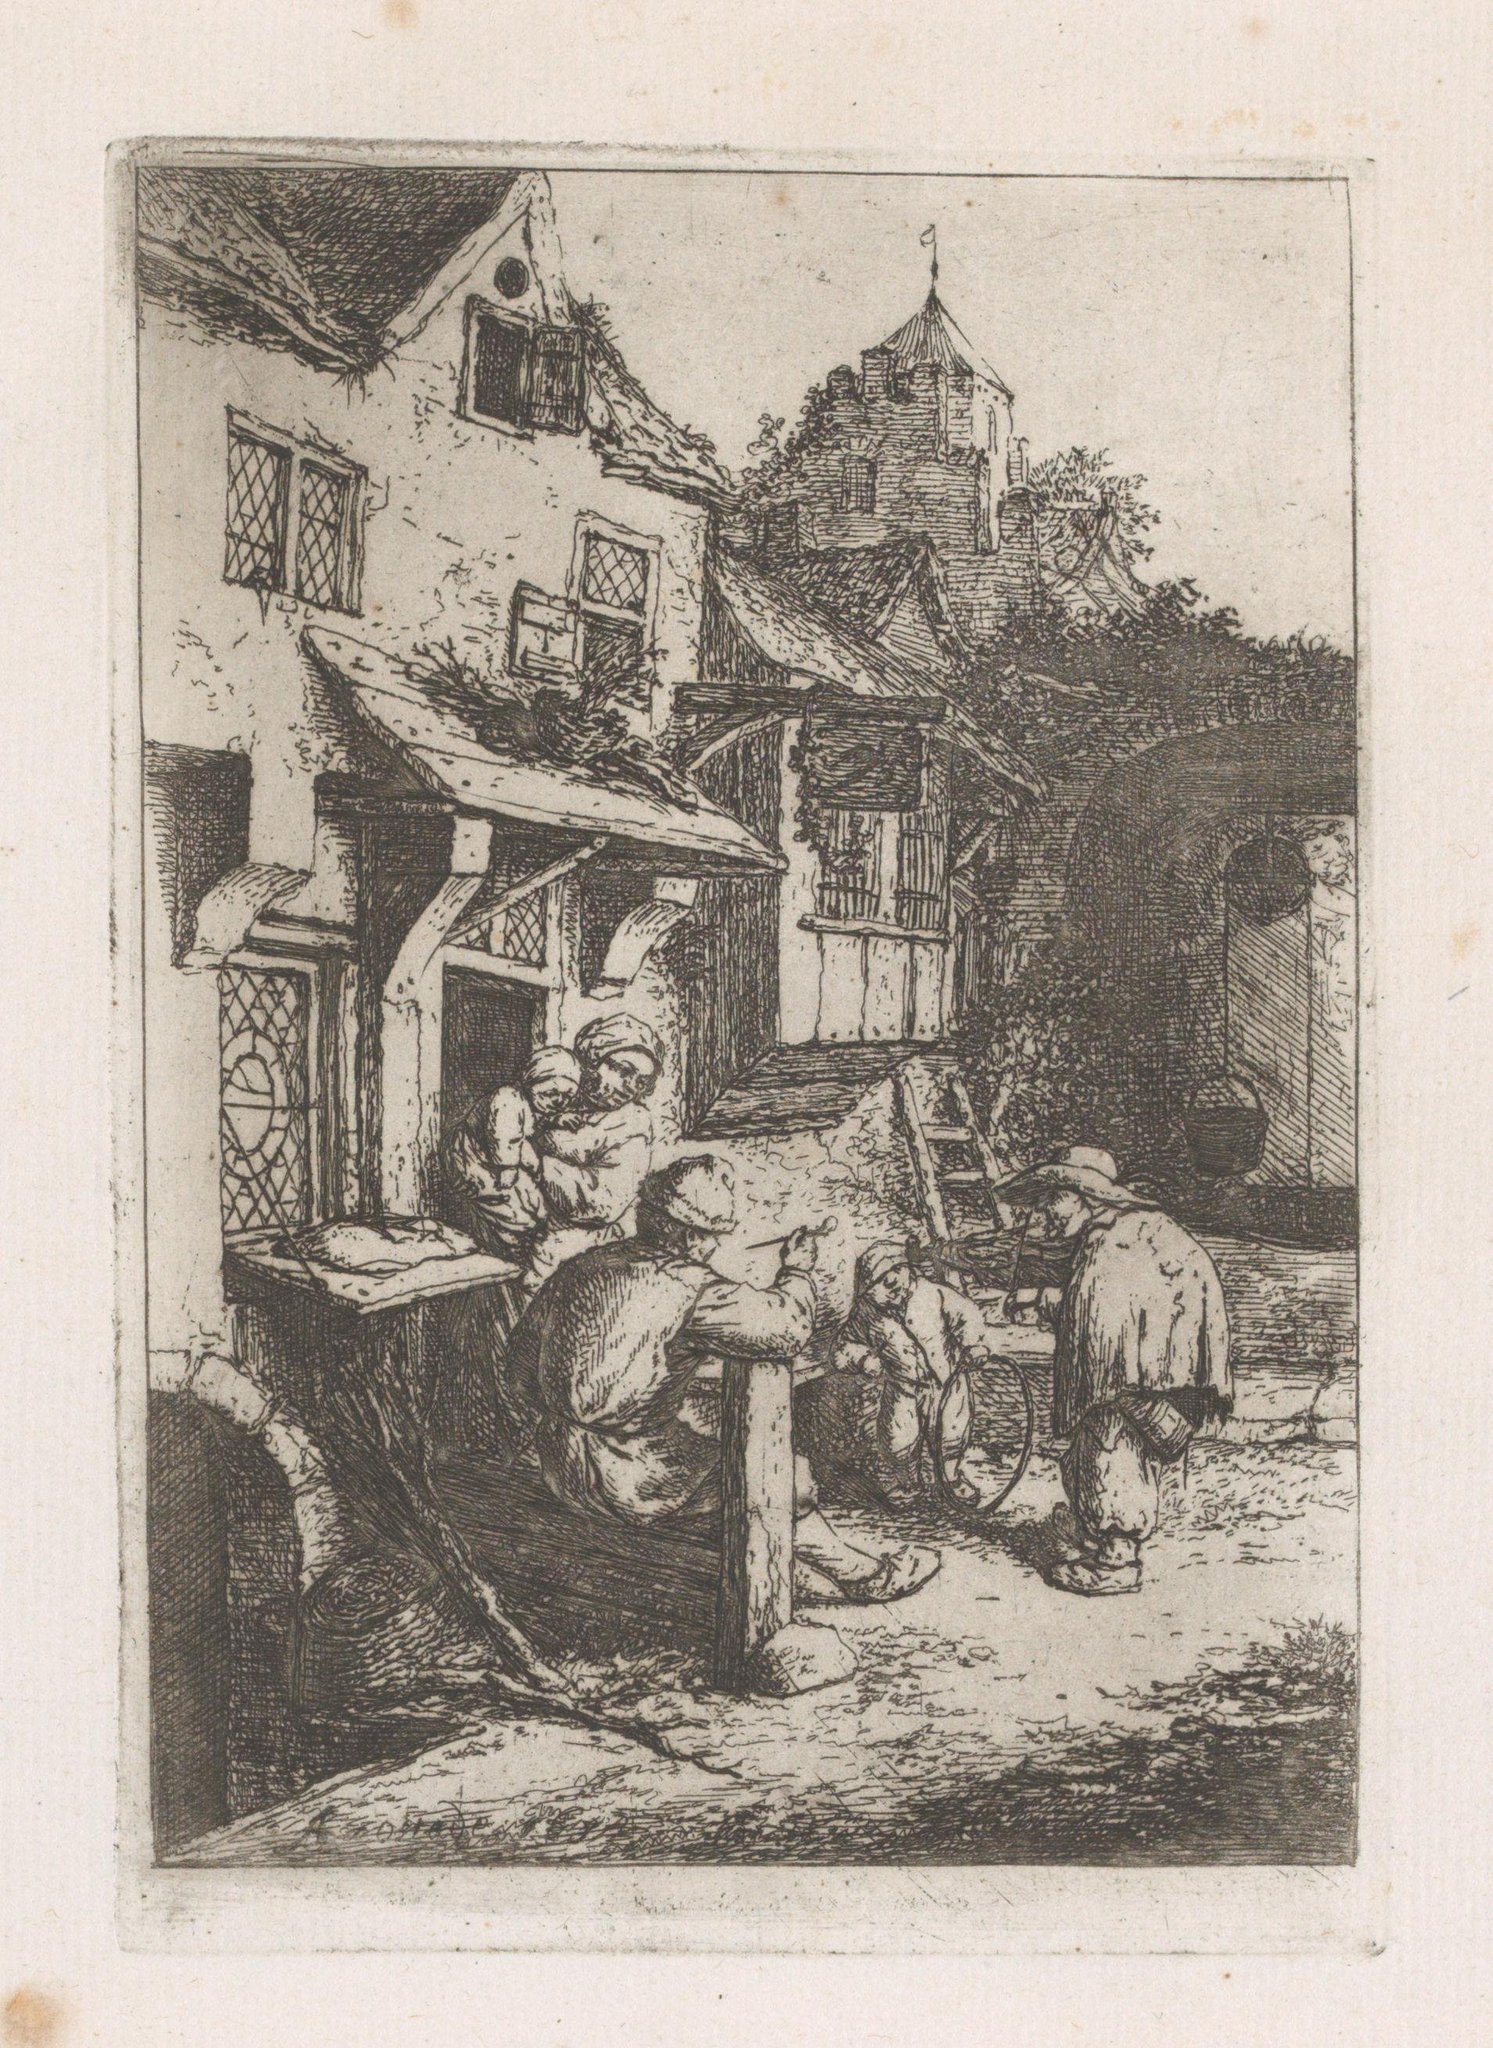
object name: print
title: Gebochelde vioolspeler voor een herberg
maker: adriaen van ostade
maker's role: draughtsman, painter, print maker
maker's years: 1610-1685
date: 1652-1656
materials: paper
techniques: etching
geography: haarlem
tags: one person playing string instrument (bowed), inn, coffee-house, public house, etc., (bowling a) hoop, hunchback, mother and baby or young child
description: Een gebochelde man speelt viool voor de ingang van een herberg. In de deuropening staat een vrouw met een klein kind op de arm. Bij haar staat een jongen met een hoepel. De man op het hek rookt een pijp. Deze prent maakt deel uit van een album.